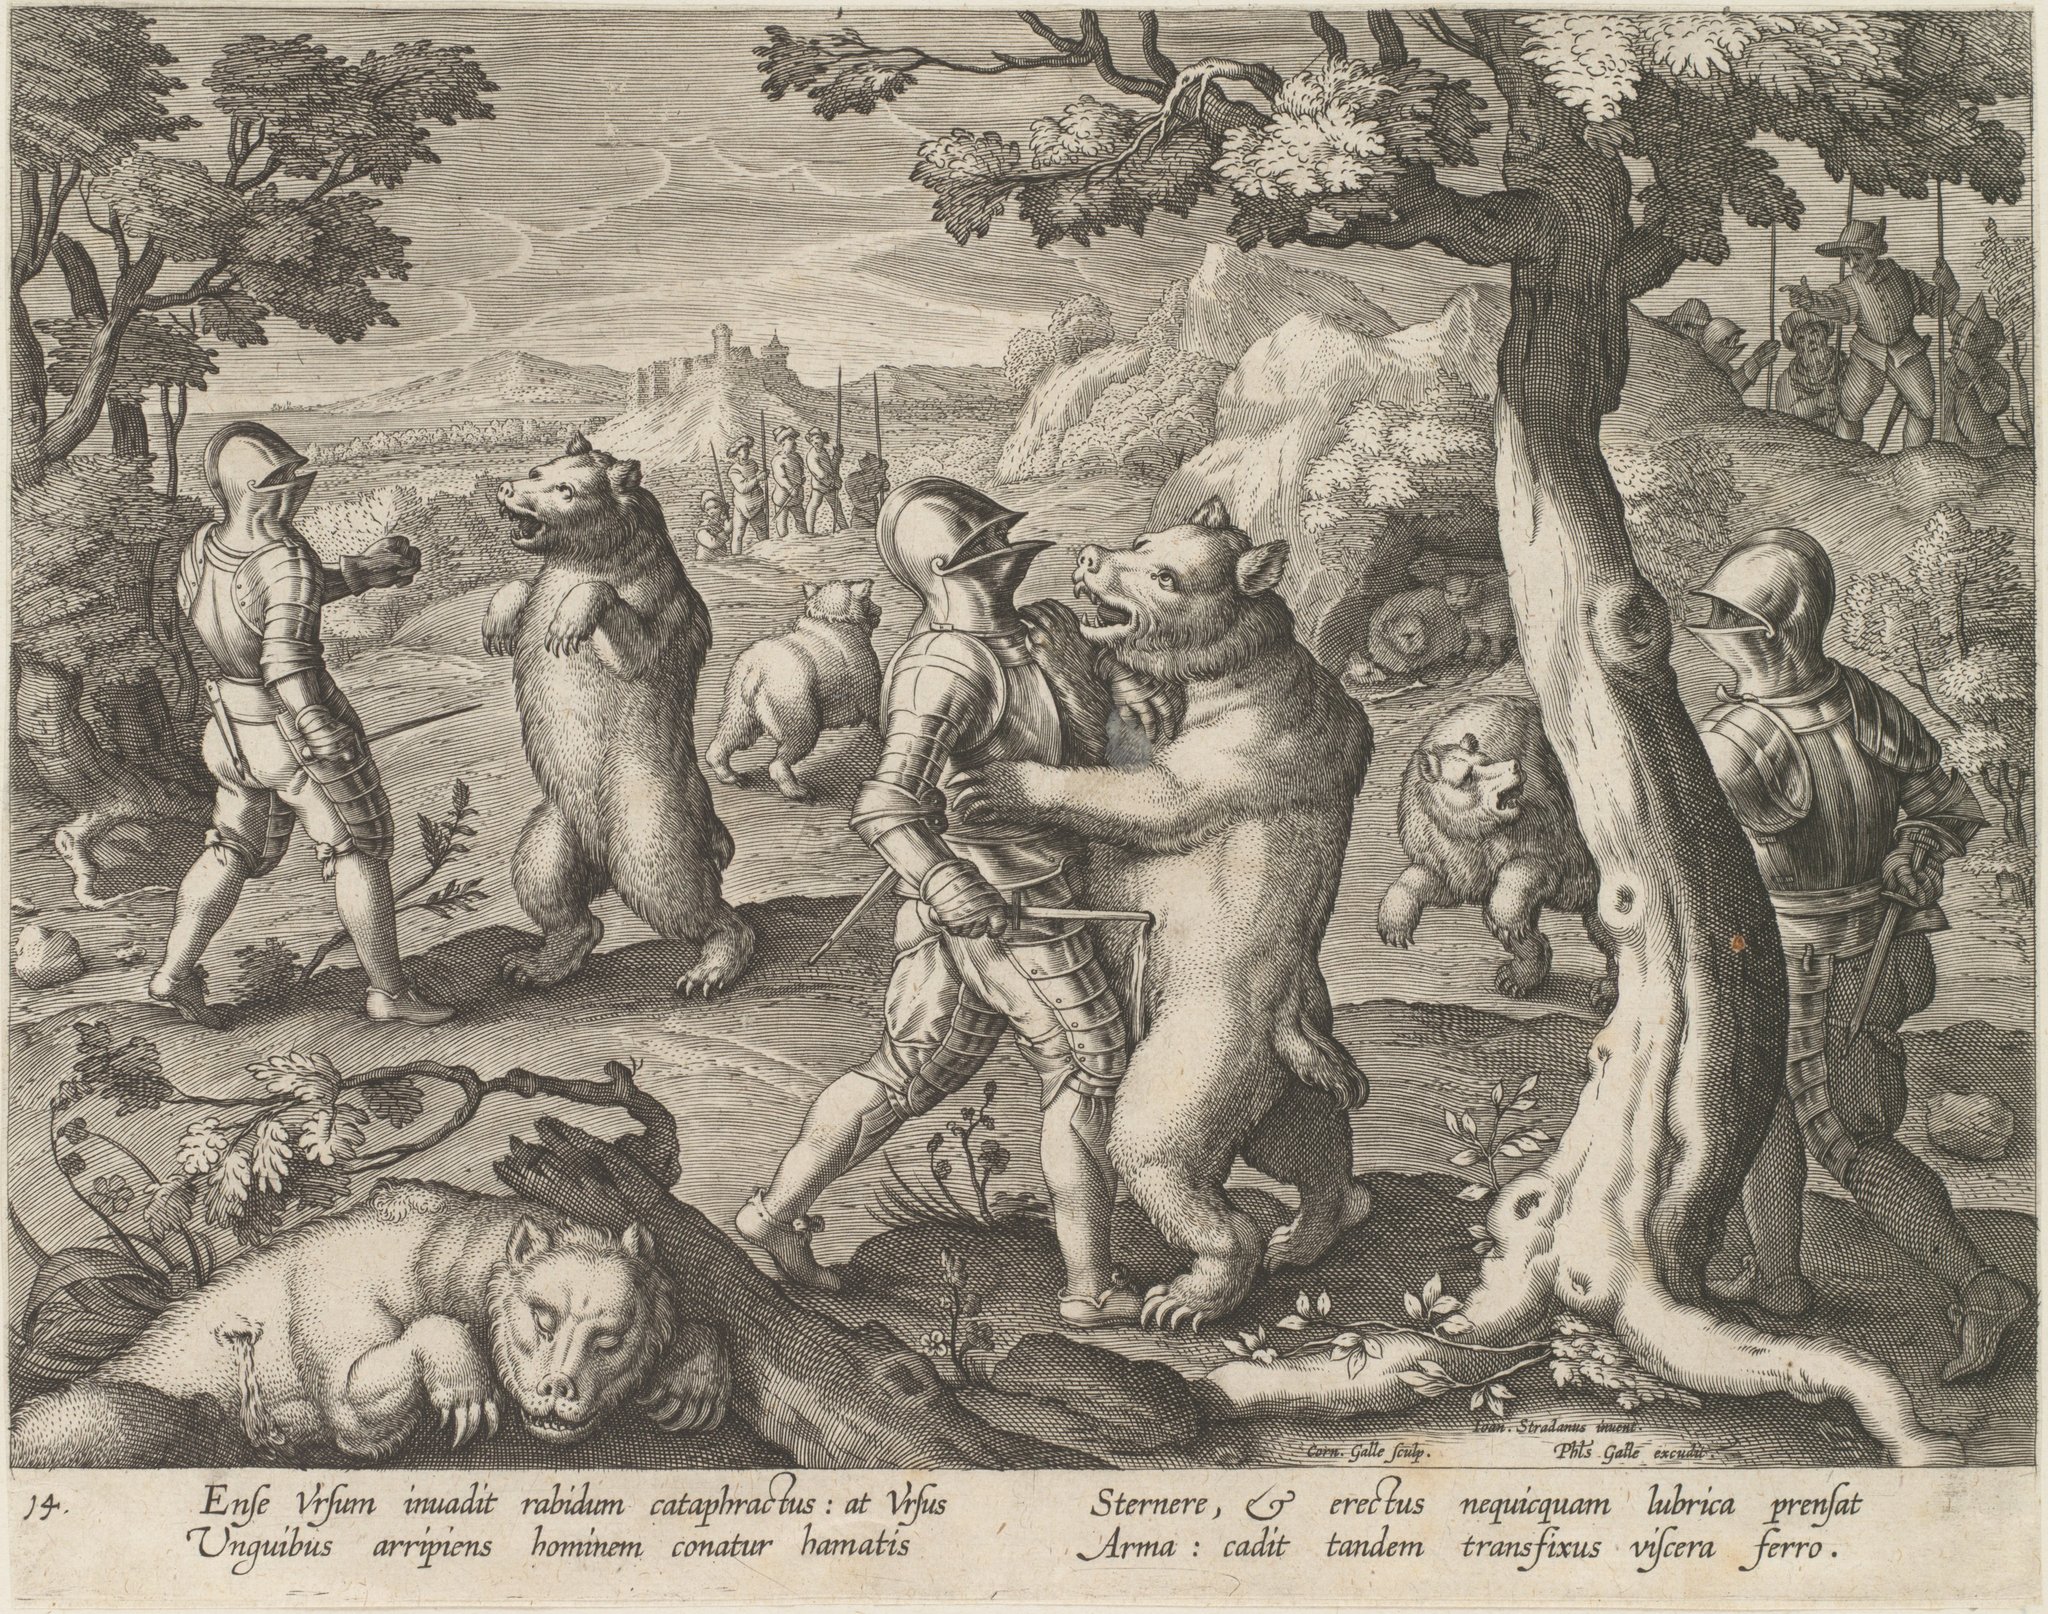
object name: print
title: Bear Hunt, from "Venationes Ferarum, Avium, Piscium..."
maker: jan van der straet, called stradanus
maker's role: artist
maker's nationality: netherlandish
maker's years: 1523-1605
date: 1501-1600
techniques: engraving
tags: human figures,bears,armor,hunting